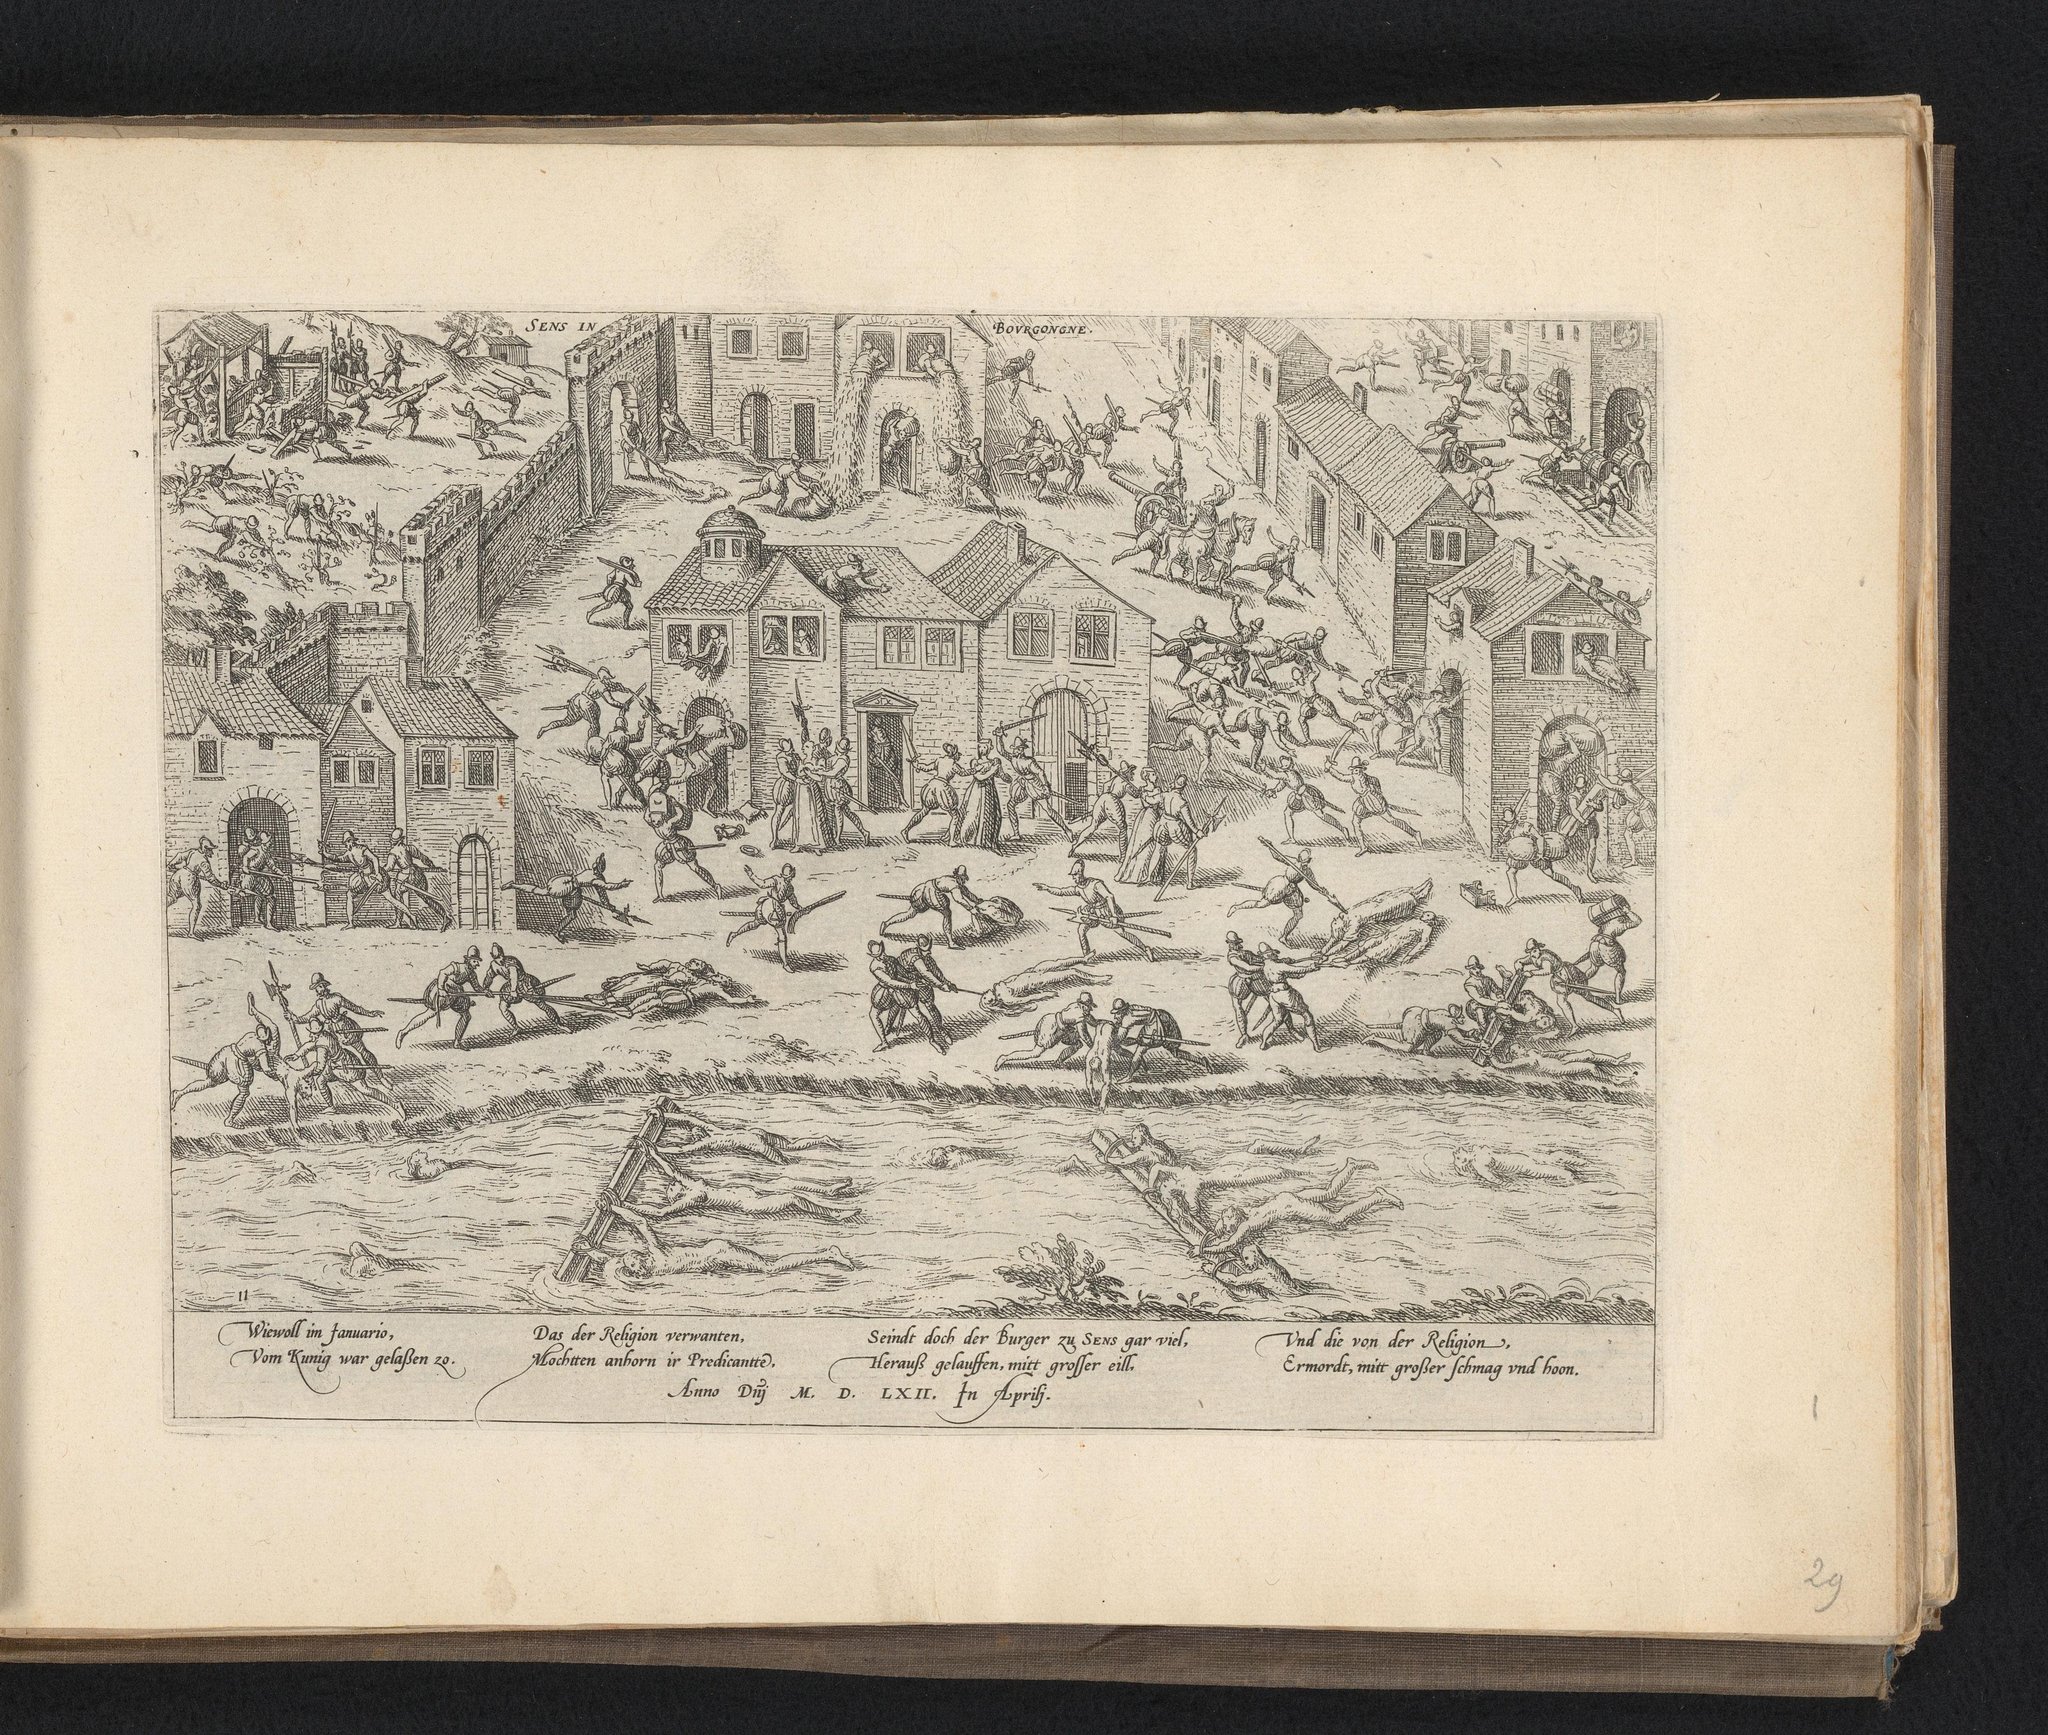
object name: print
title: Moord op de protestanten te Sens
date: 1562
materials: paper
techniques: etching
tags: militant proselytizing: religious war, crusade, etc., murder, the roman catholic church vs. protestantism; (reformation and counter reformation)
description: Prent gebruikt in: Aitsinger, Michael. De Leone Belgico (...). Keulen: s.n., 1588.